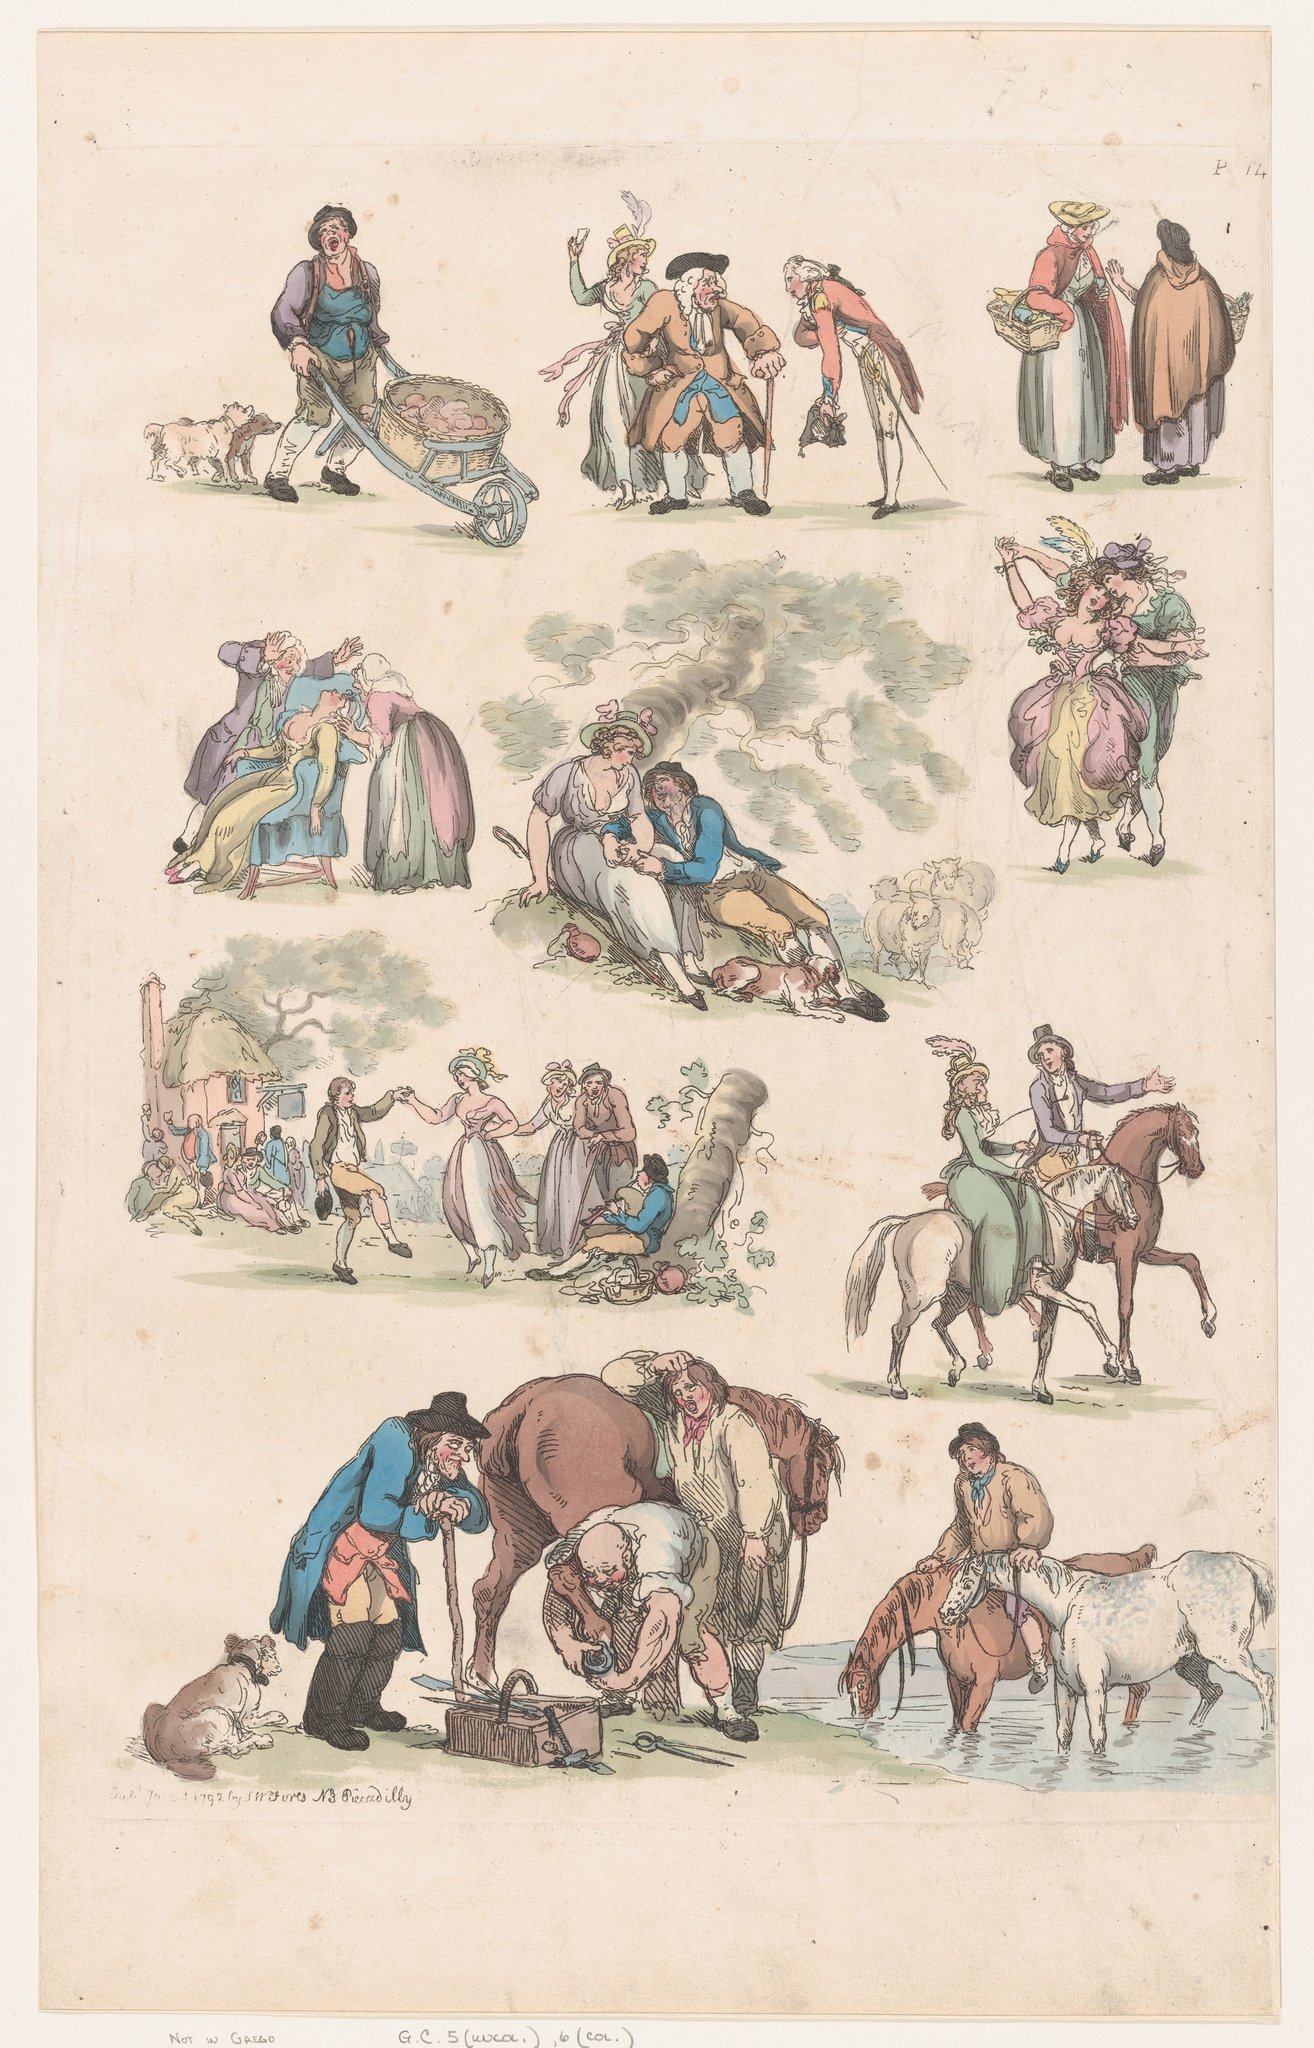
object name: print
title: Plate 14, Outlines of Figures, Landscapes and Cattle...for the Use of Learners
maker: thomas rowlandson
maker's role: artist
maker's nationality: british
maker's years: 1757-1827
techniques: etching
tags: men,women,dancing,horses,working